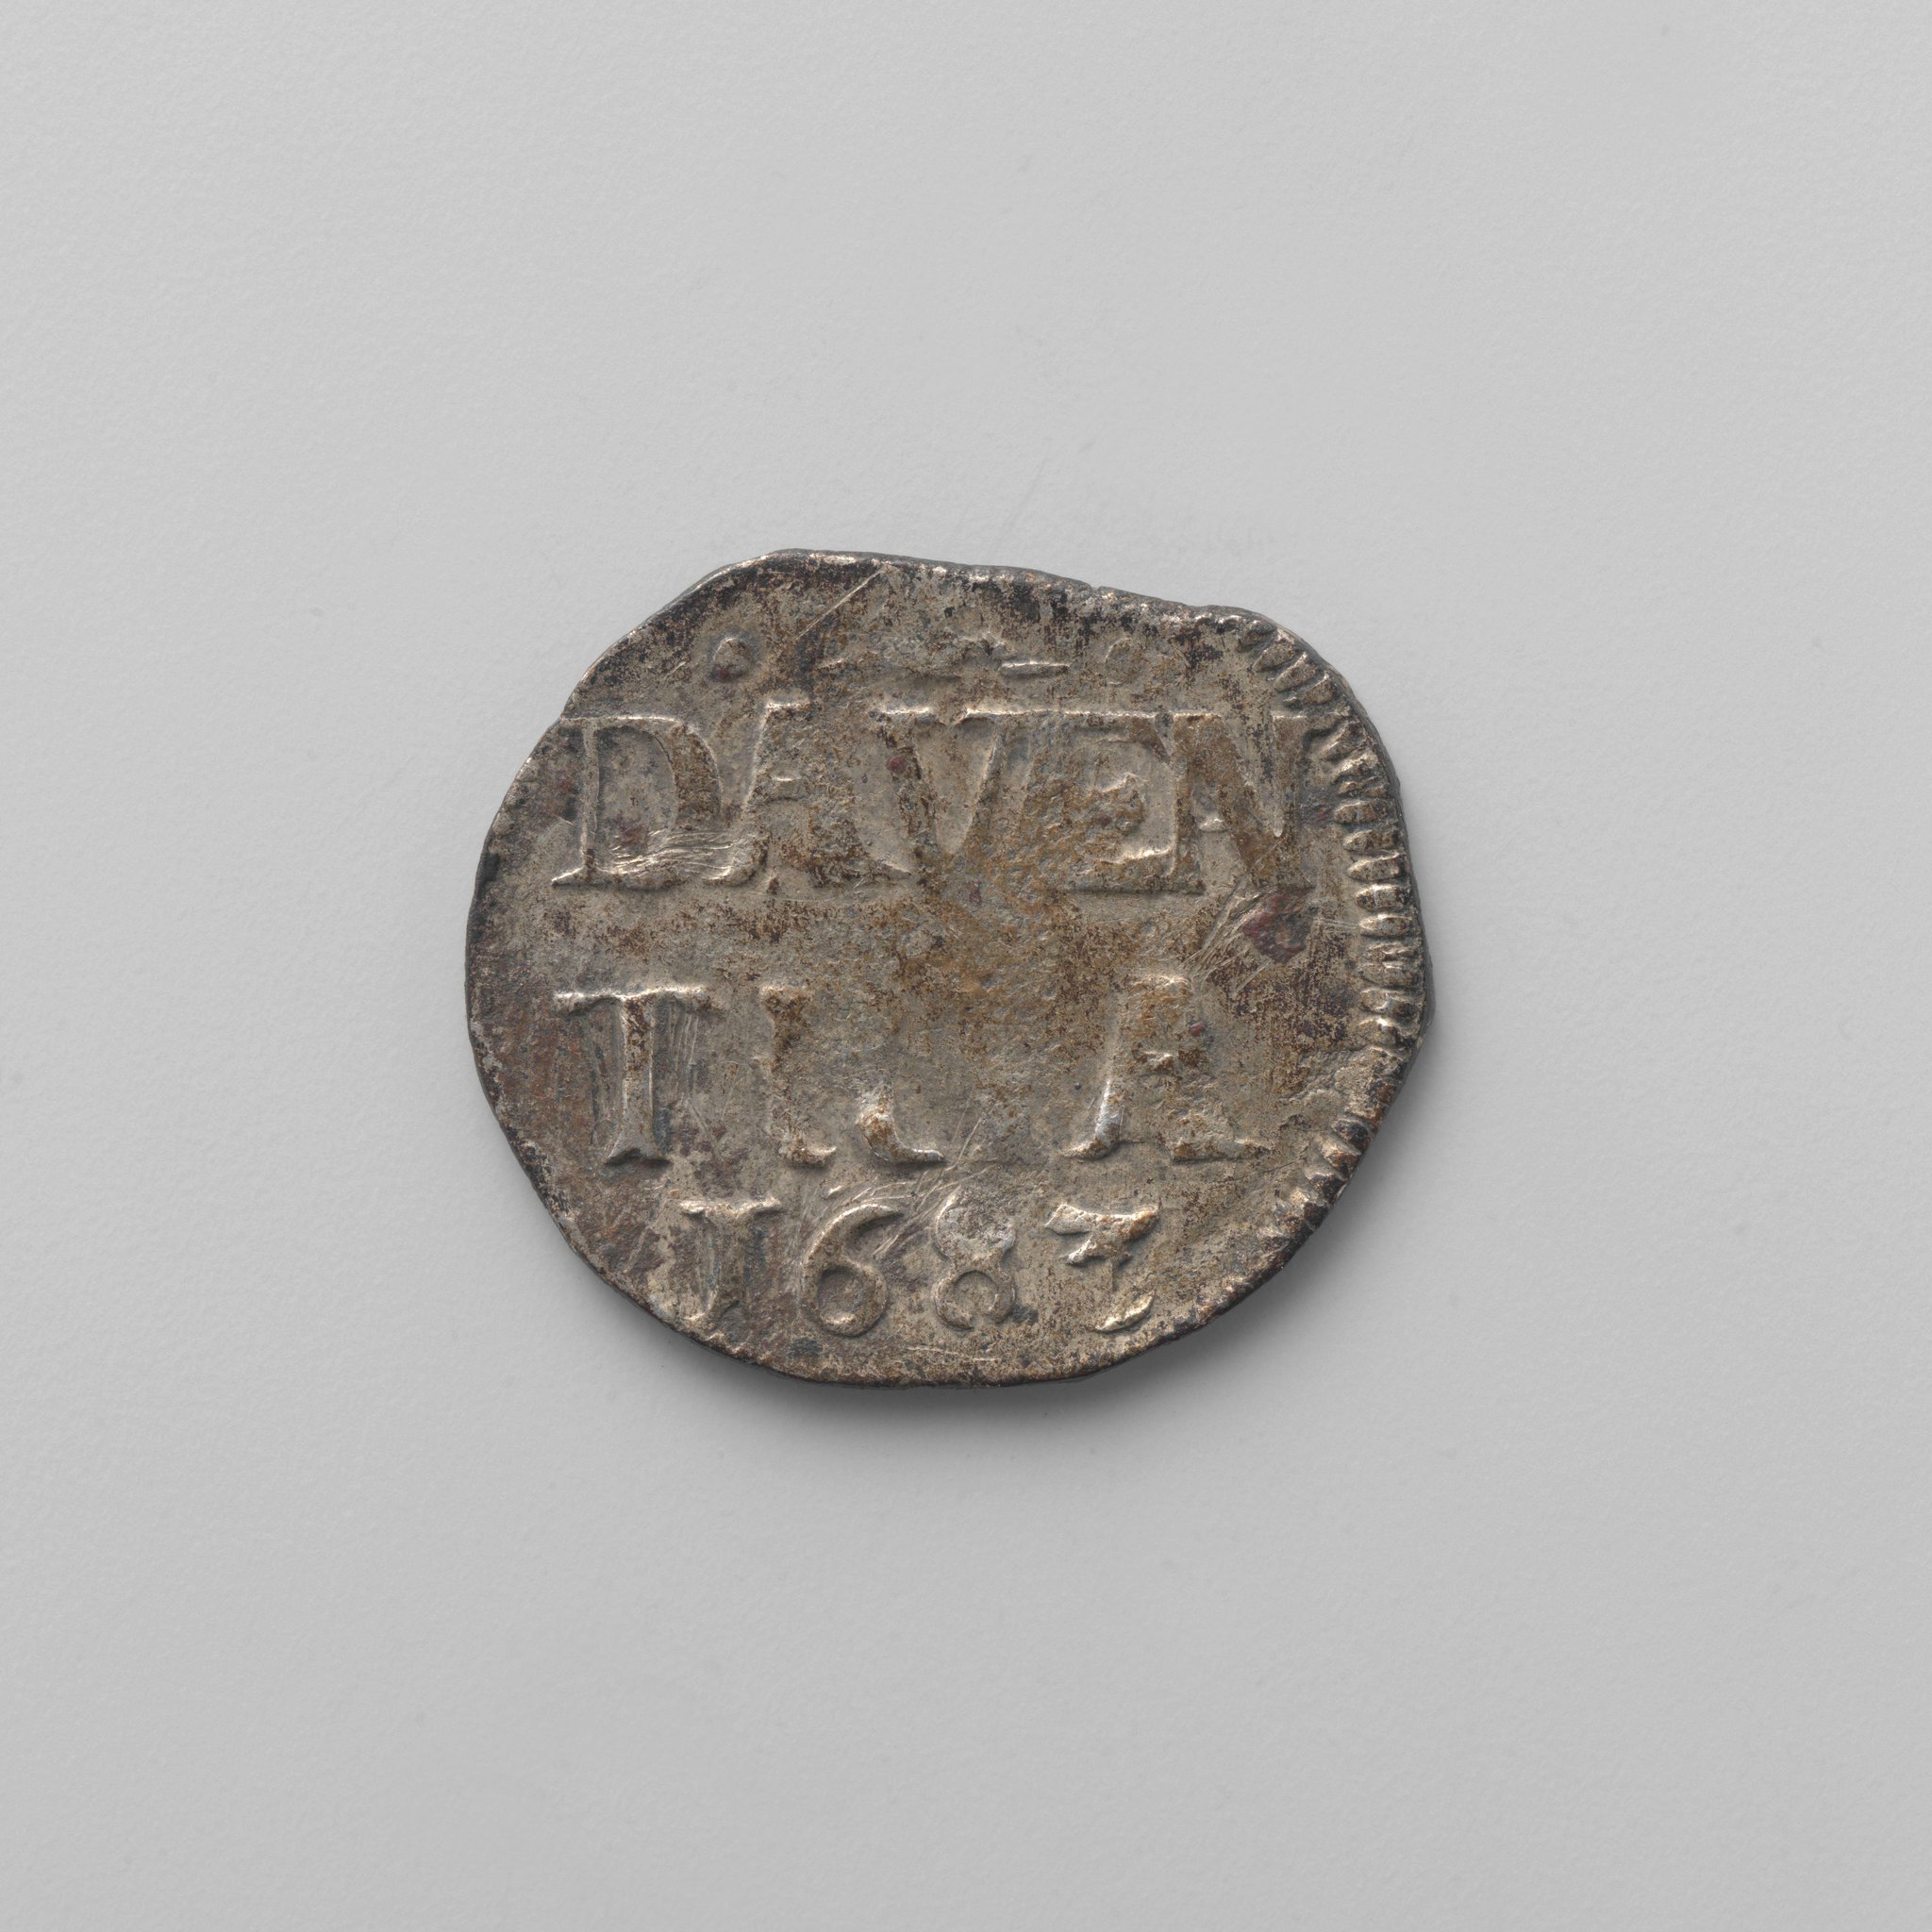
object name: coin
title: Dubbele stuiver van Deventer, 1683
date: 1683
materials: silver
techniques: striking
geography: deventer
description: Zilveren munt. Voorzijde: tussen waarde-aanduiding 2 S generaliteitsleeuw. Keerzijde: tweeregelig opschrift. Daarboven muntmeesterteken en daaronder jaartal.